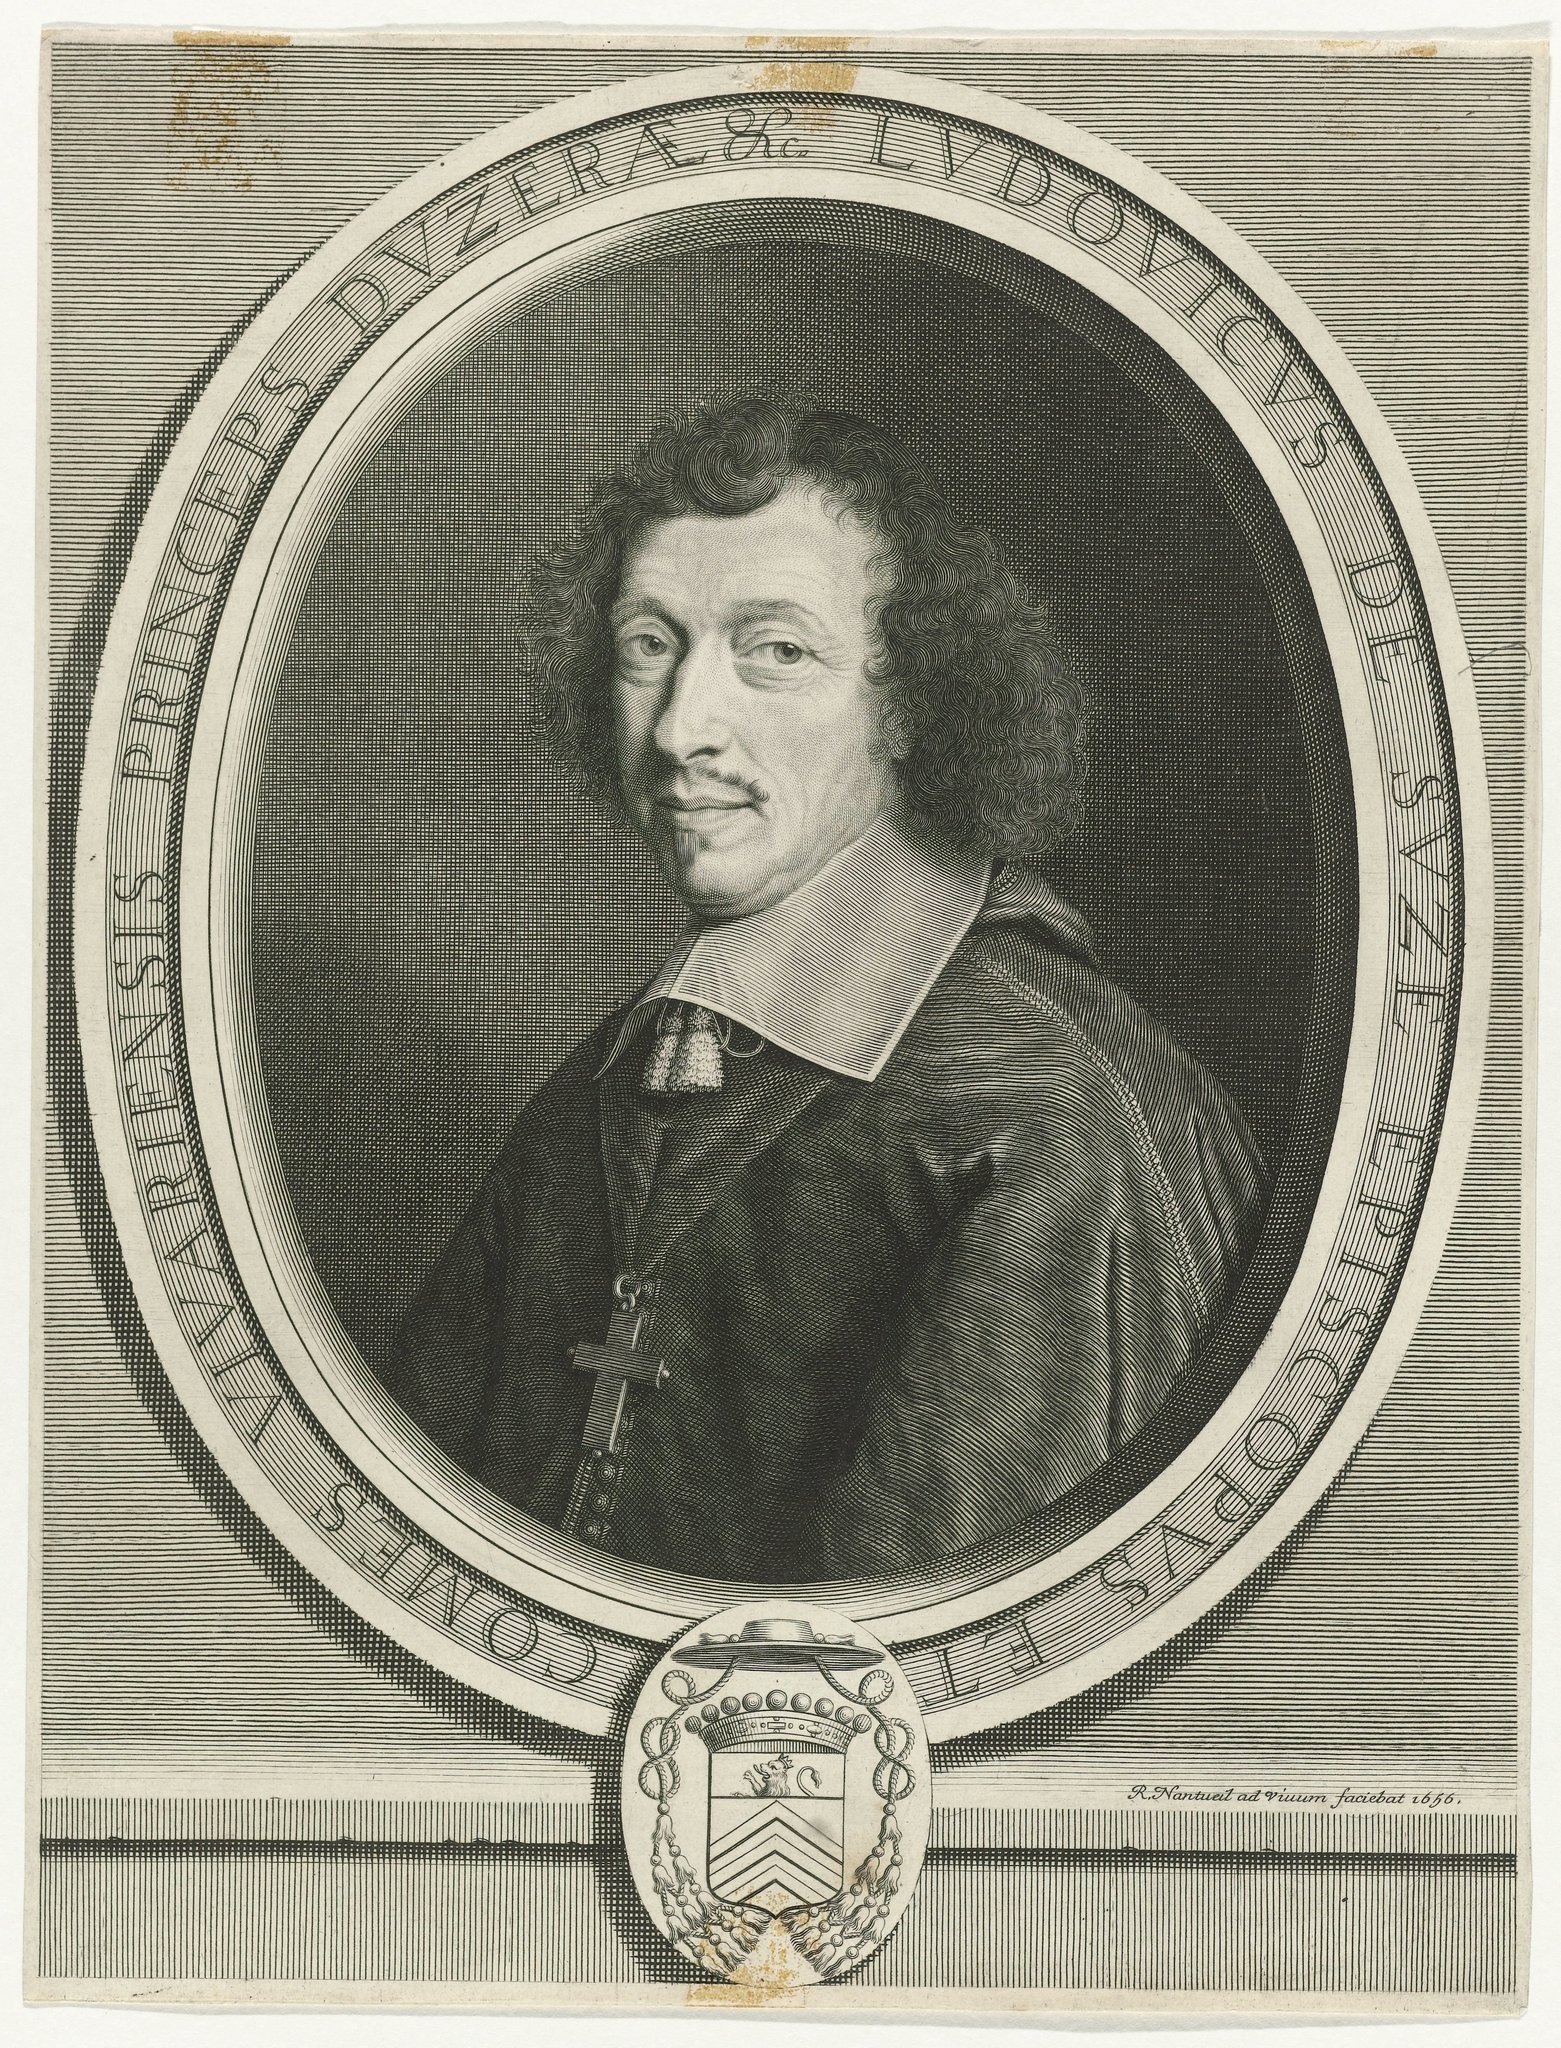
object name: print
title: Portret Louis François de la Baume de Suze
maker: robert nanteuil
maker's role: print maker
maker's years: 1623-1678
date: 1656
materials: paper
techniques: engraving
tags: louis-françois de la baume de suze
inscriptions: date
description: Buste naar links, gekleed in toga met crucifix op de borst, in ovale lijst met randschrift. Wapen middenonder.